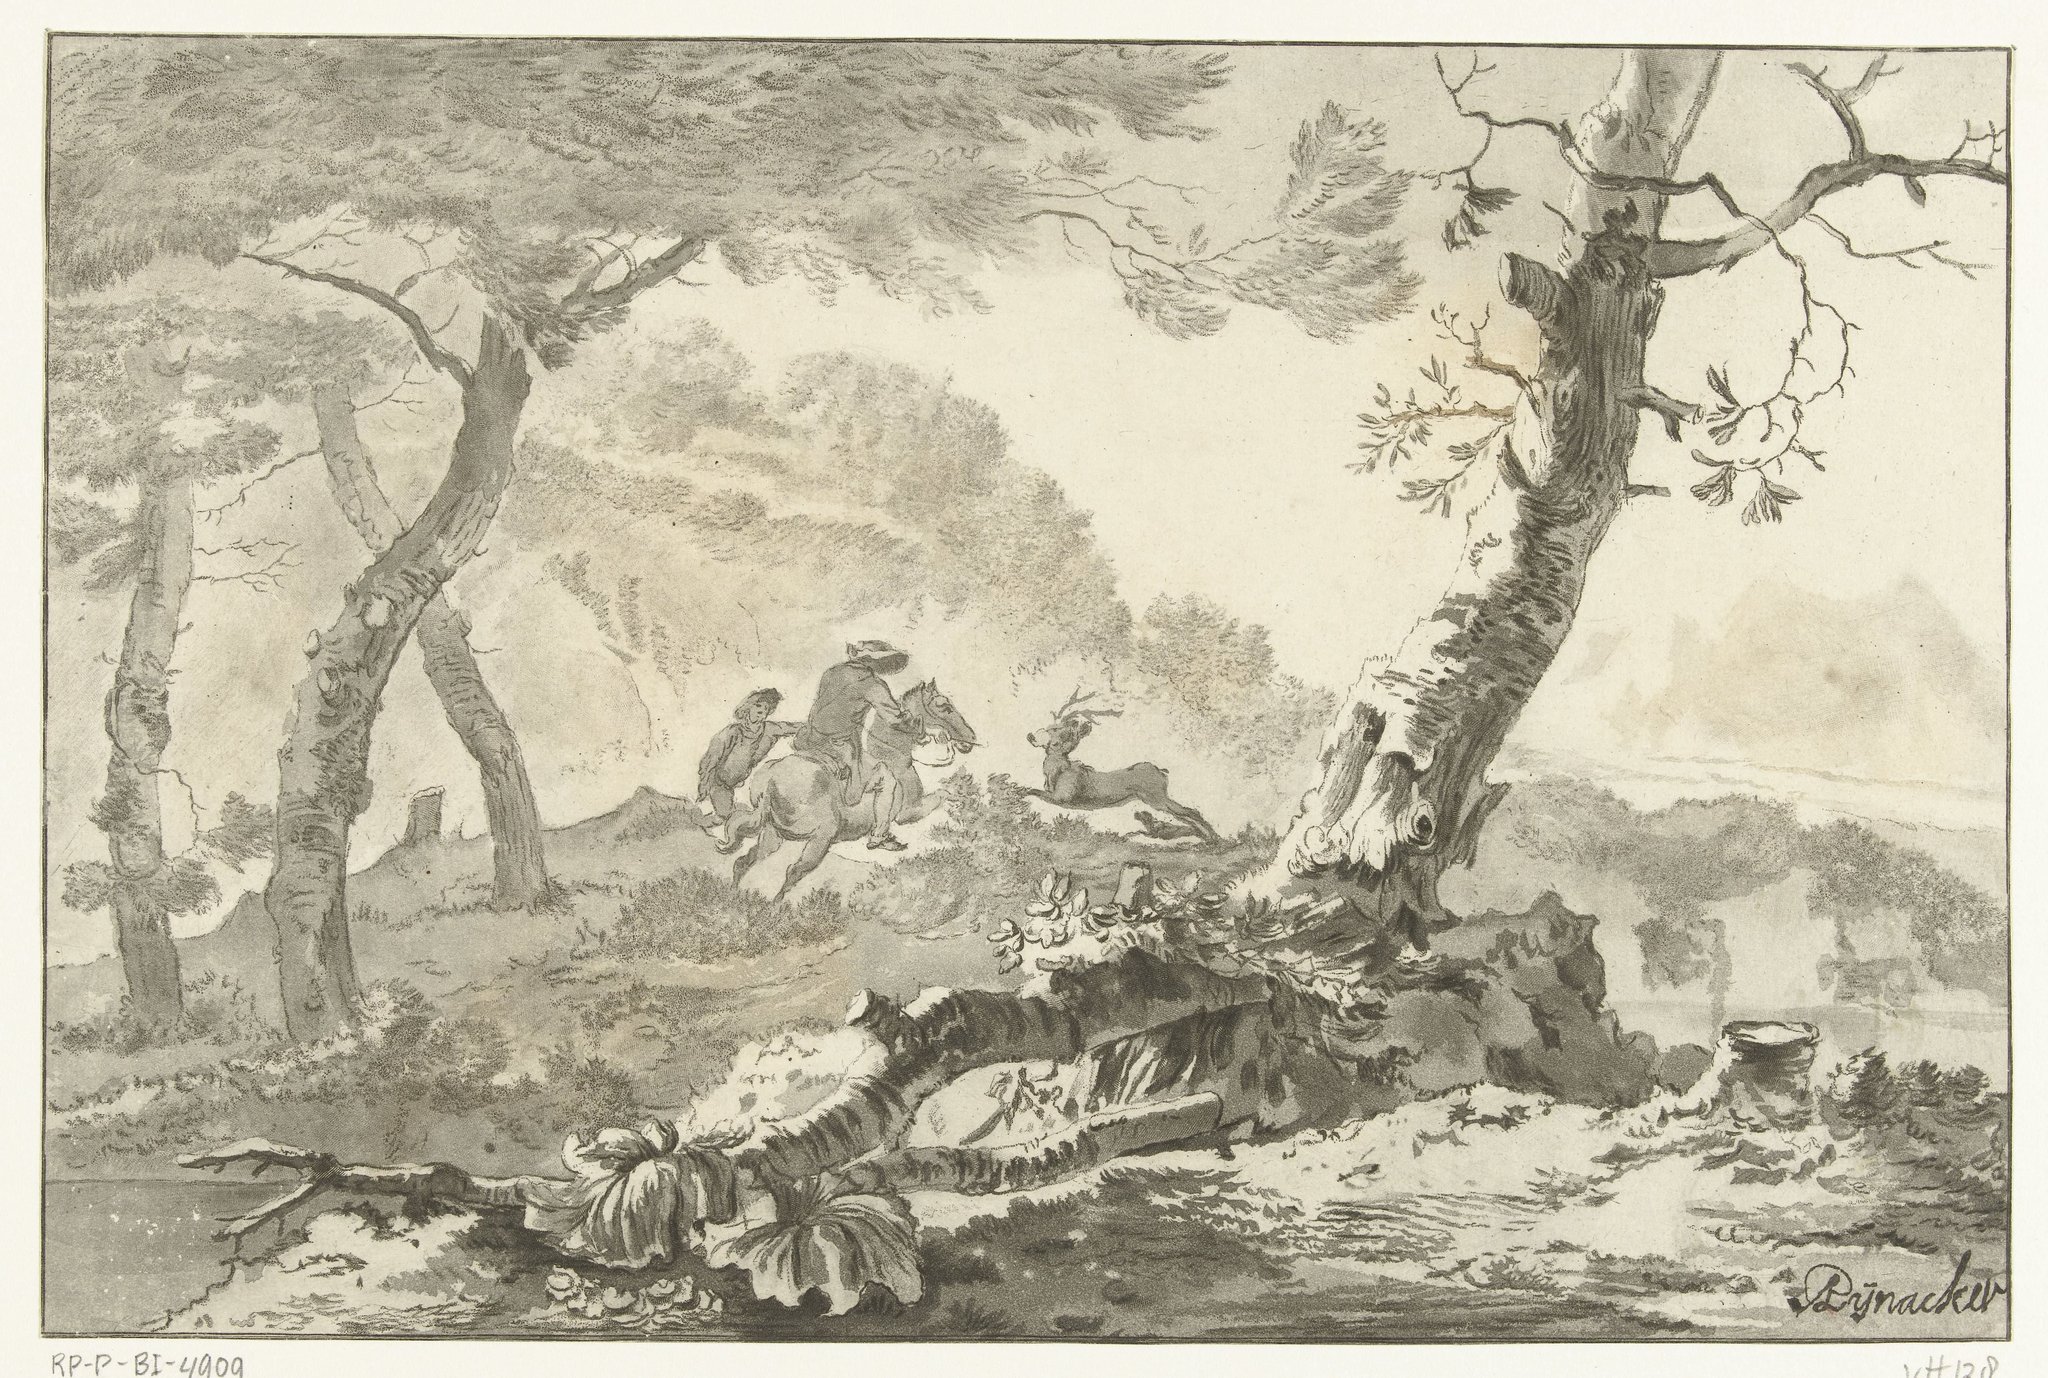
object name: print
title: Landschap met hertenjacht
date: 1741-1803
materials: paper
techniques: aquatint, printmaking, roulette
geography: netherlands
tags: stag-hunting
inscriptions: collector's mark: Lugt 12, collector's mark: Lugt 2527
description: Prent naar tekening van Adam Pijnacker welke zich bevindt in de collectie van het Amsterdams Historisch Museum te Amsterdam. Prent uit serie van negen prenttekeningen met acht landschappen en een zeegezicht naar Hollandse meesters uit de 17e eeuw, zie Huffel 1921, p. 33-35. Deze serie werd door Christiaan Josi opgenomen in een uitgave met 100 werken naar Hollandse en Vlaamse meesters: Collection d'imitations de dessins d'après les principaux maîtres hollandais et flamands, Londen, C.Josi, 1821. Alle prenten in deze uitgave dragen op het verso het wapen van Cornelis Ploos van Amstel, de initiatiefnemer voor de uitgave.